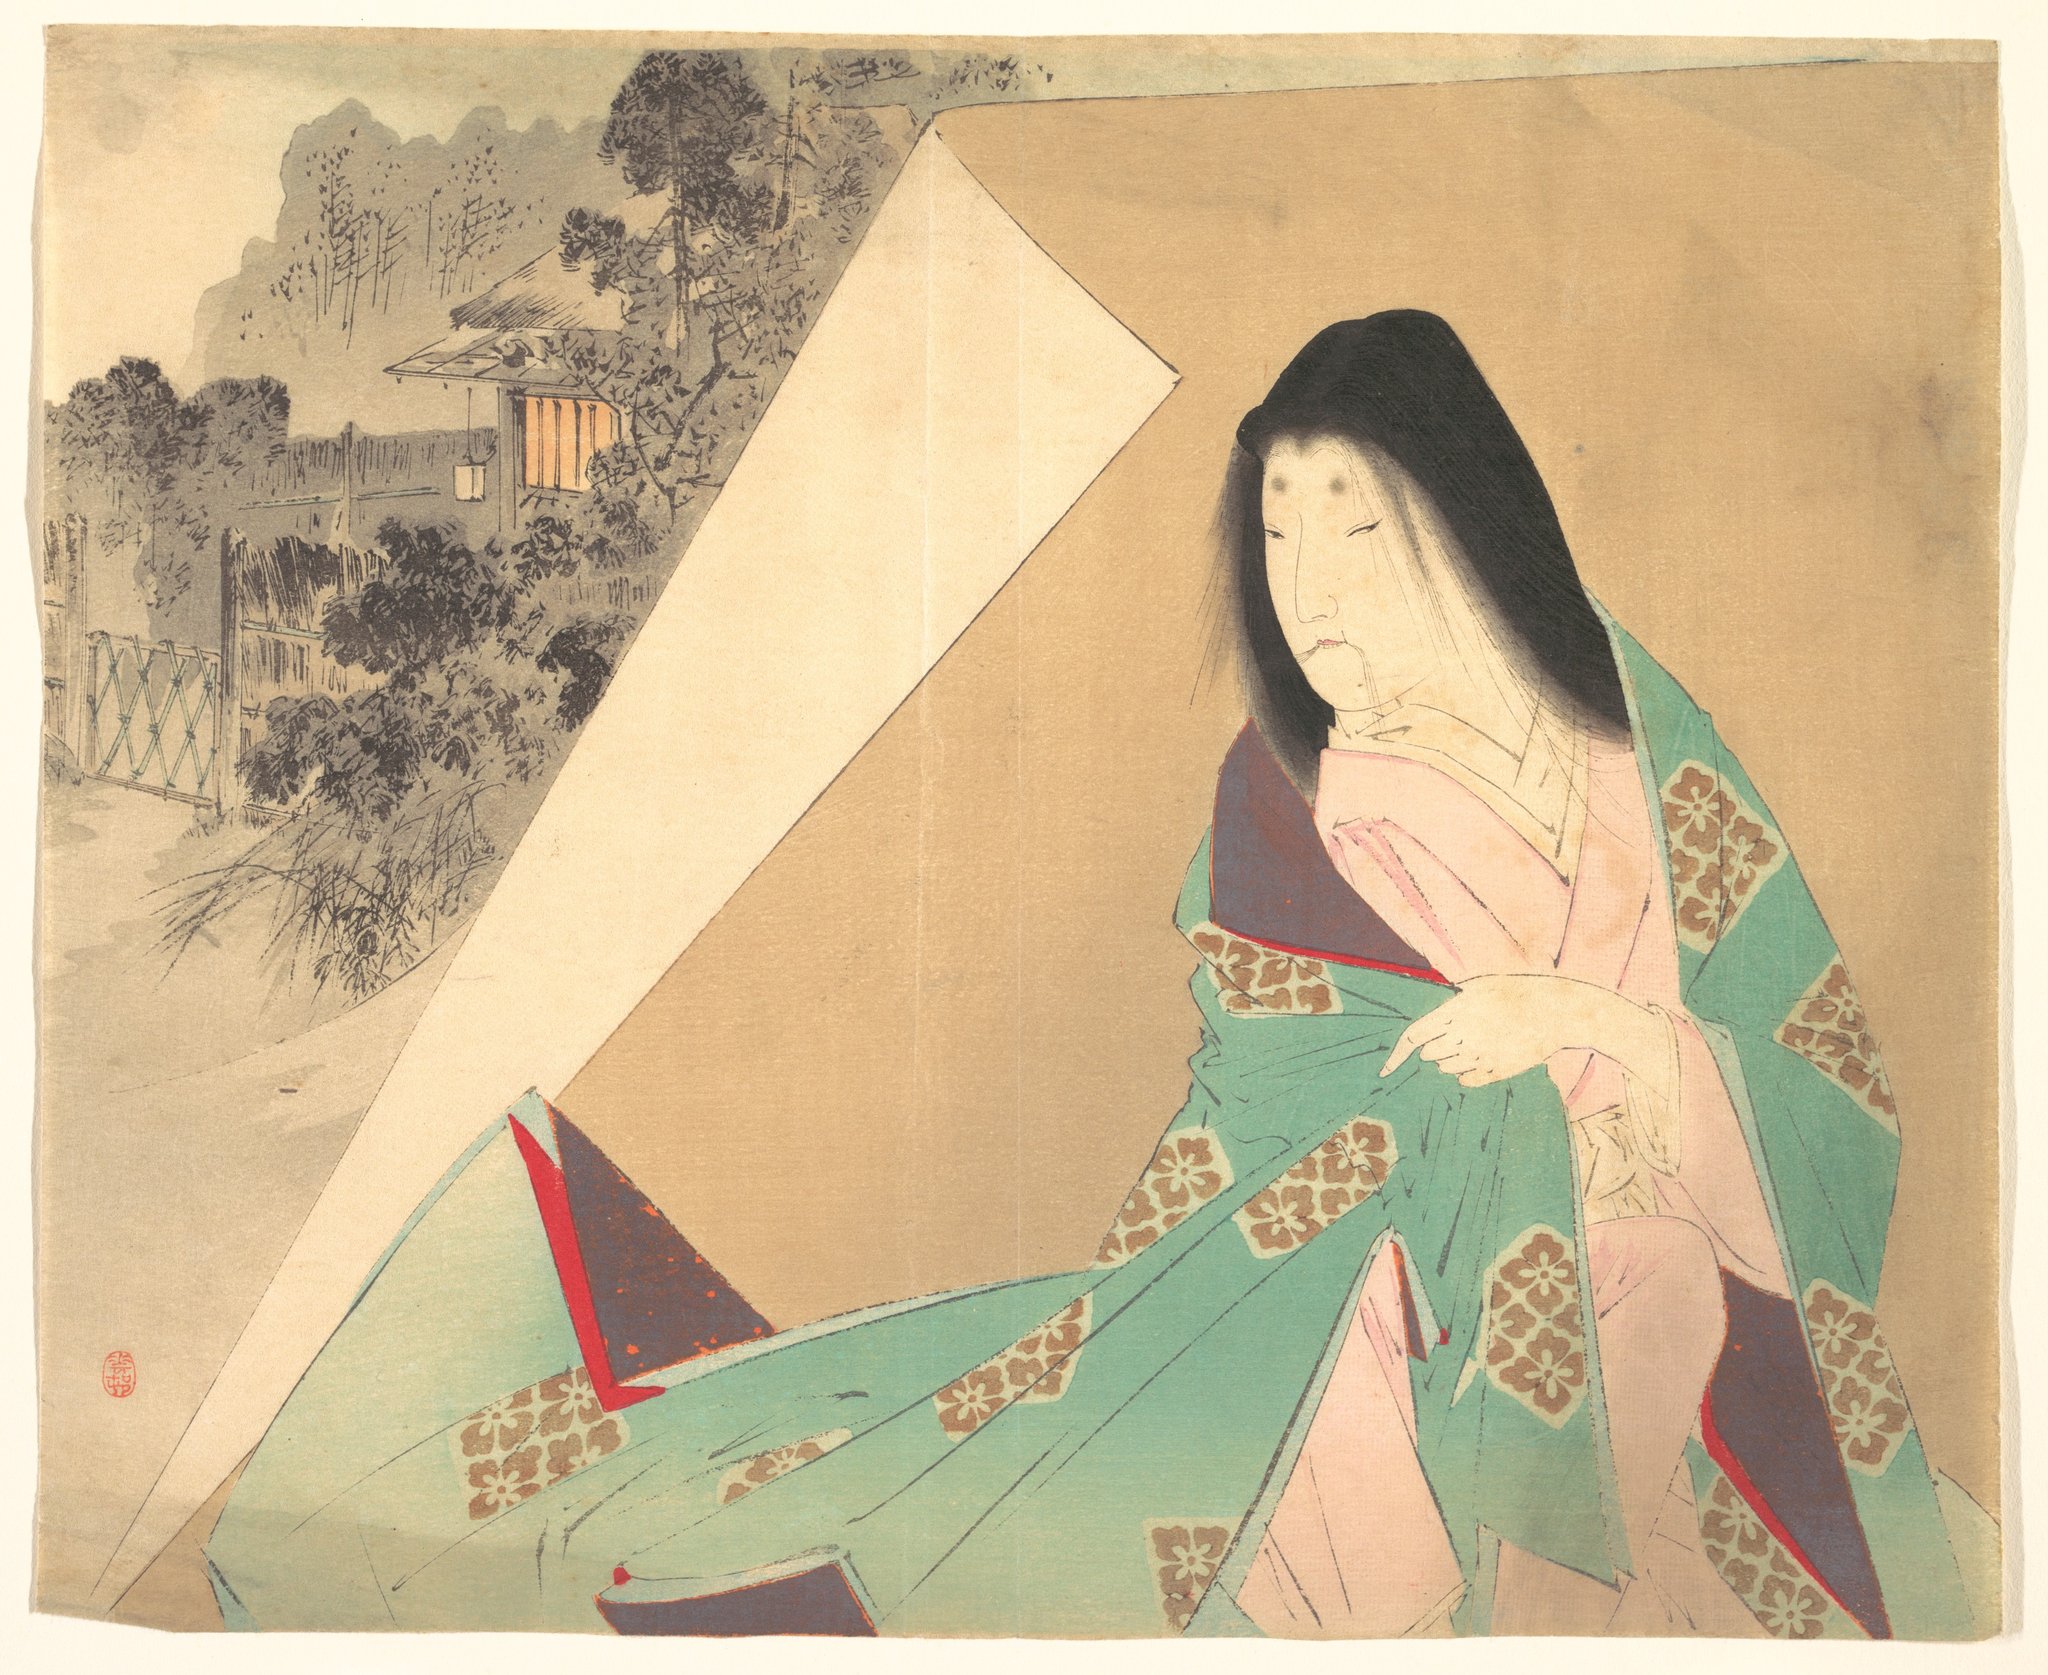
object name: print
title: The Daughter Manju, illustration from Bugei Kurabu (Literary Club)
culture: japanese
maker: suzuki kason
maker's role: artist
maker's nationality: japanese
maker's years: 1860-1919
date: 1906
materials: ink, paper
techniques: woodblock print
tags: houses,women,trees